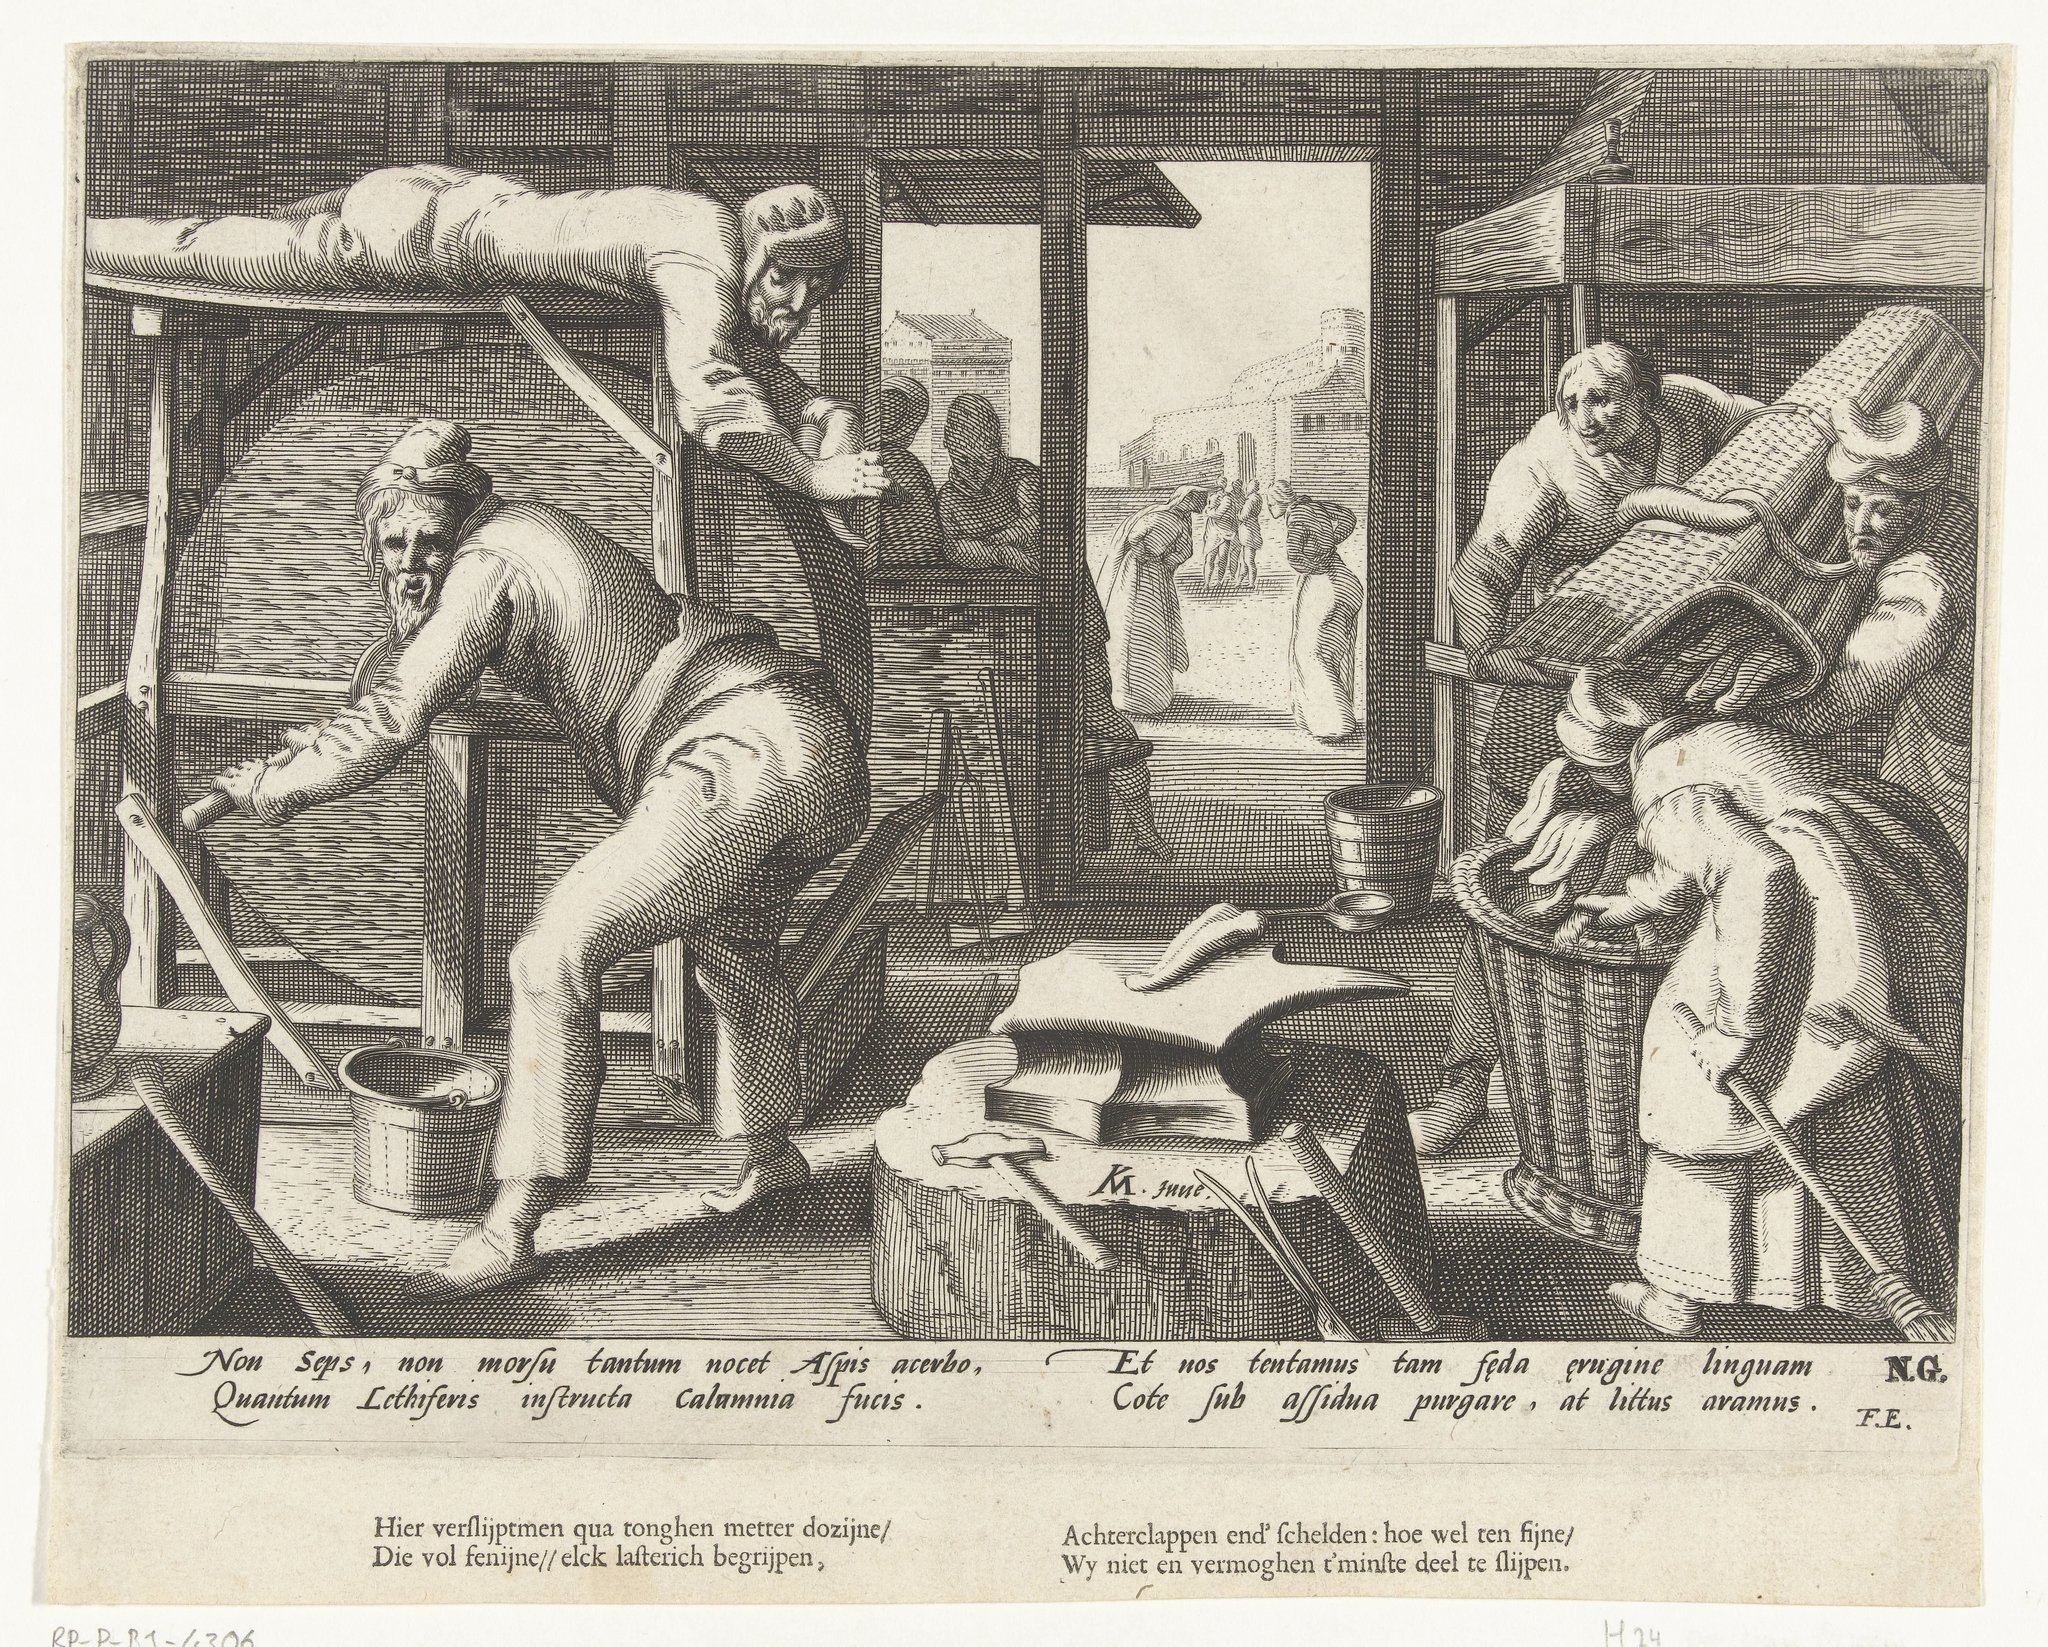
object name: print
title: Tongenslijper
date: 1590-1594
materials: paper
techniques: engraving, letterpress printing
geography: haarlem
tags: tongue stuck out, grinding, milling (industrial processes), ways pretending to cure simpletons (folklore)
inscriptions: collector's mark: Lugt 2228, collector's mark: Lugt 1967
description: In een werkplaats worden tongen geslepen. Twee mannen legen een draagmand met tongen in een grote mand. Een vrouw met een bezem houdt de mand vast. Links ligt een man op een stellage van een slijpsteen en slijpt een tong. Een andere man draait de slijpsteen. In het midden een aambeeld met gereedschap, waarop een tong ligt. Voor de werkplaats maken twee vrouwen ruzie. Onder de voorstelling een Latijns vers van Franco Estius en een Nederlands vers.